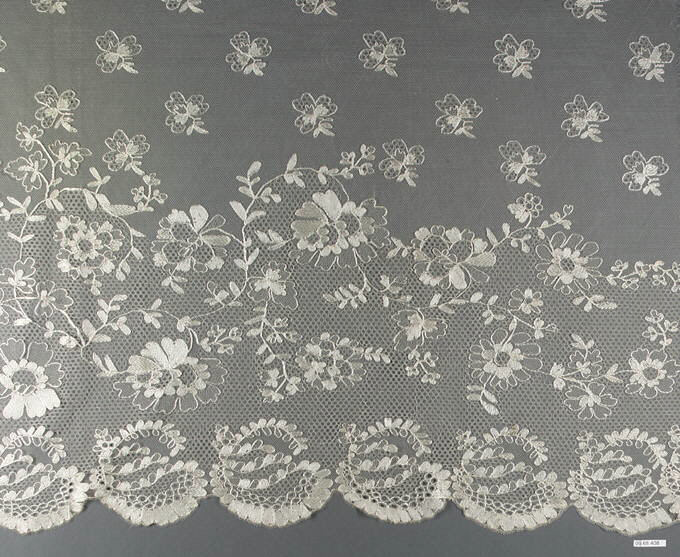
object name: flounce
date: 1801-1900